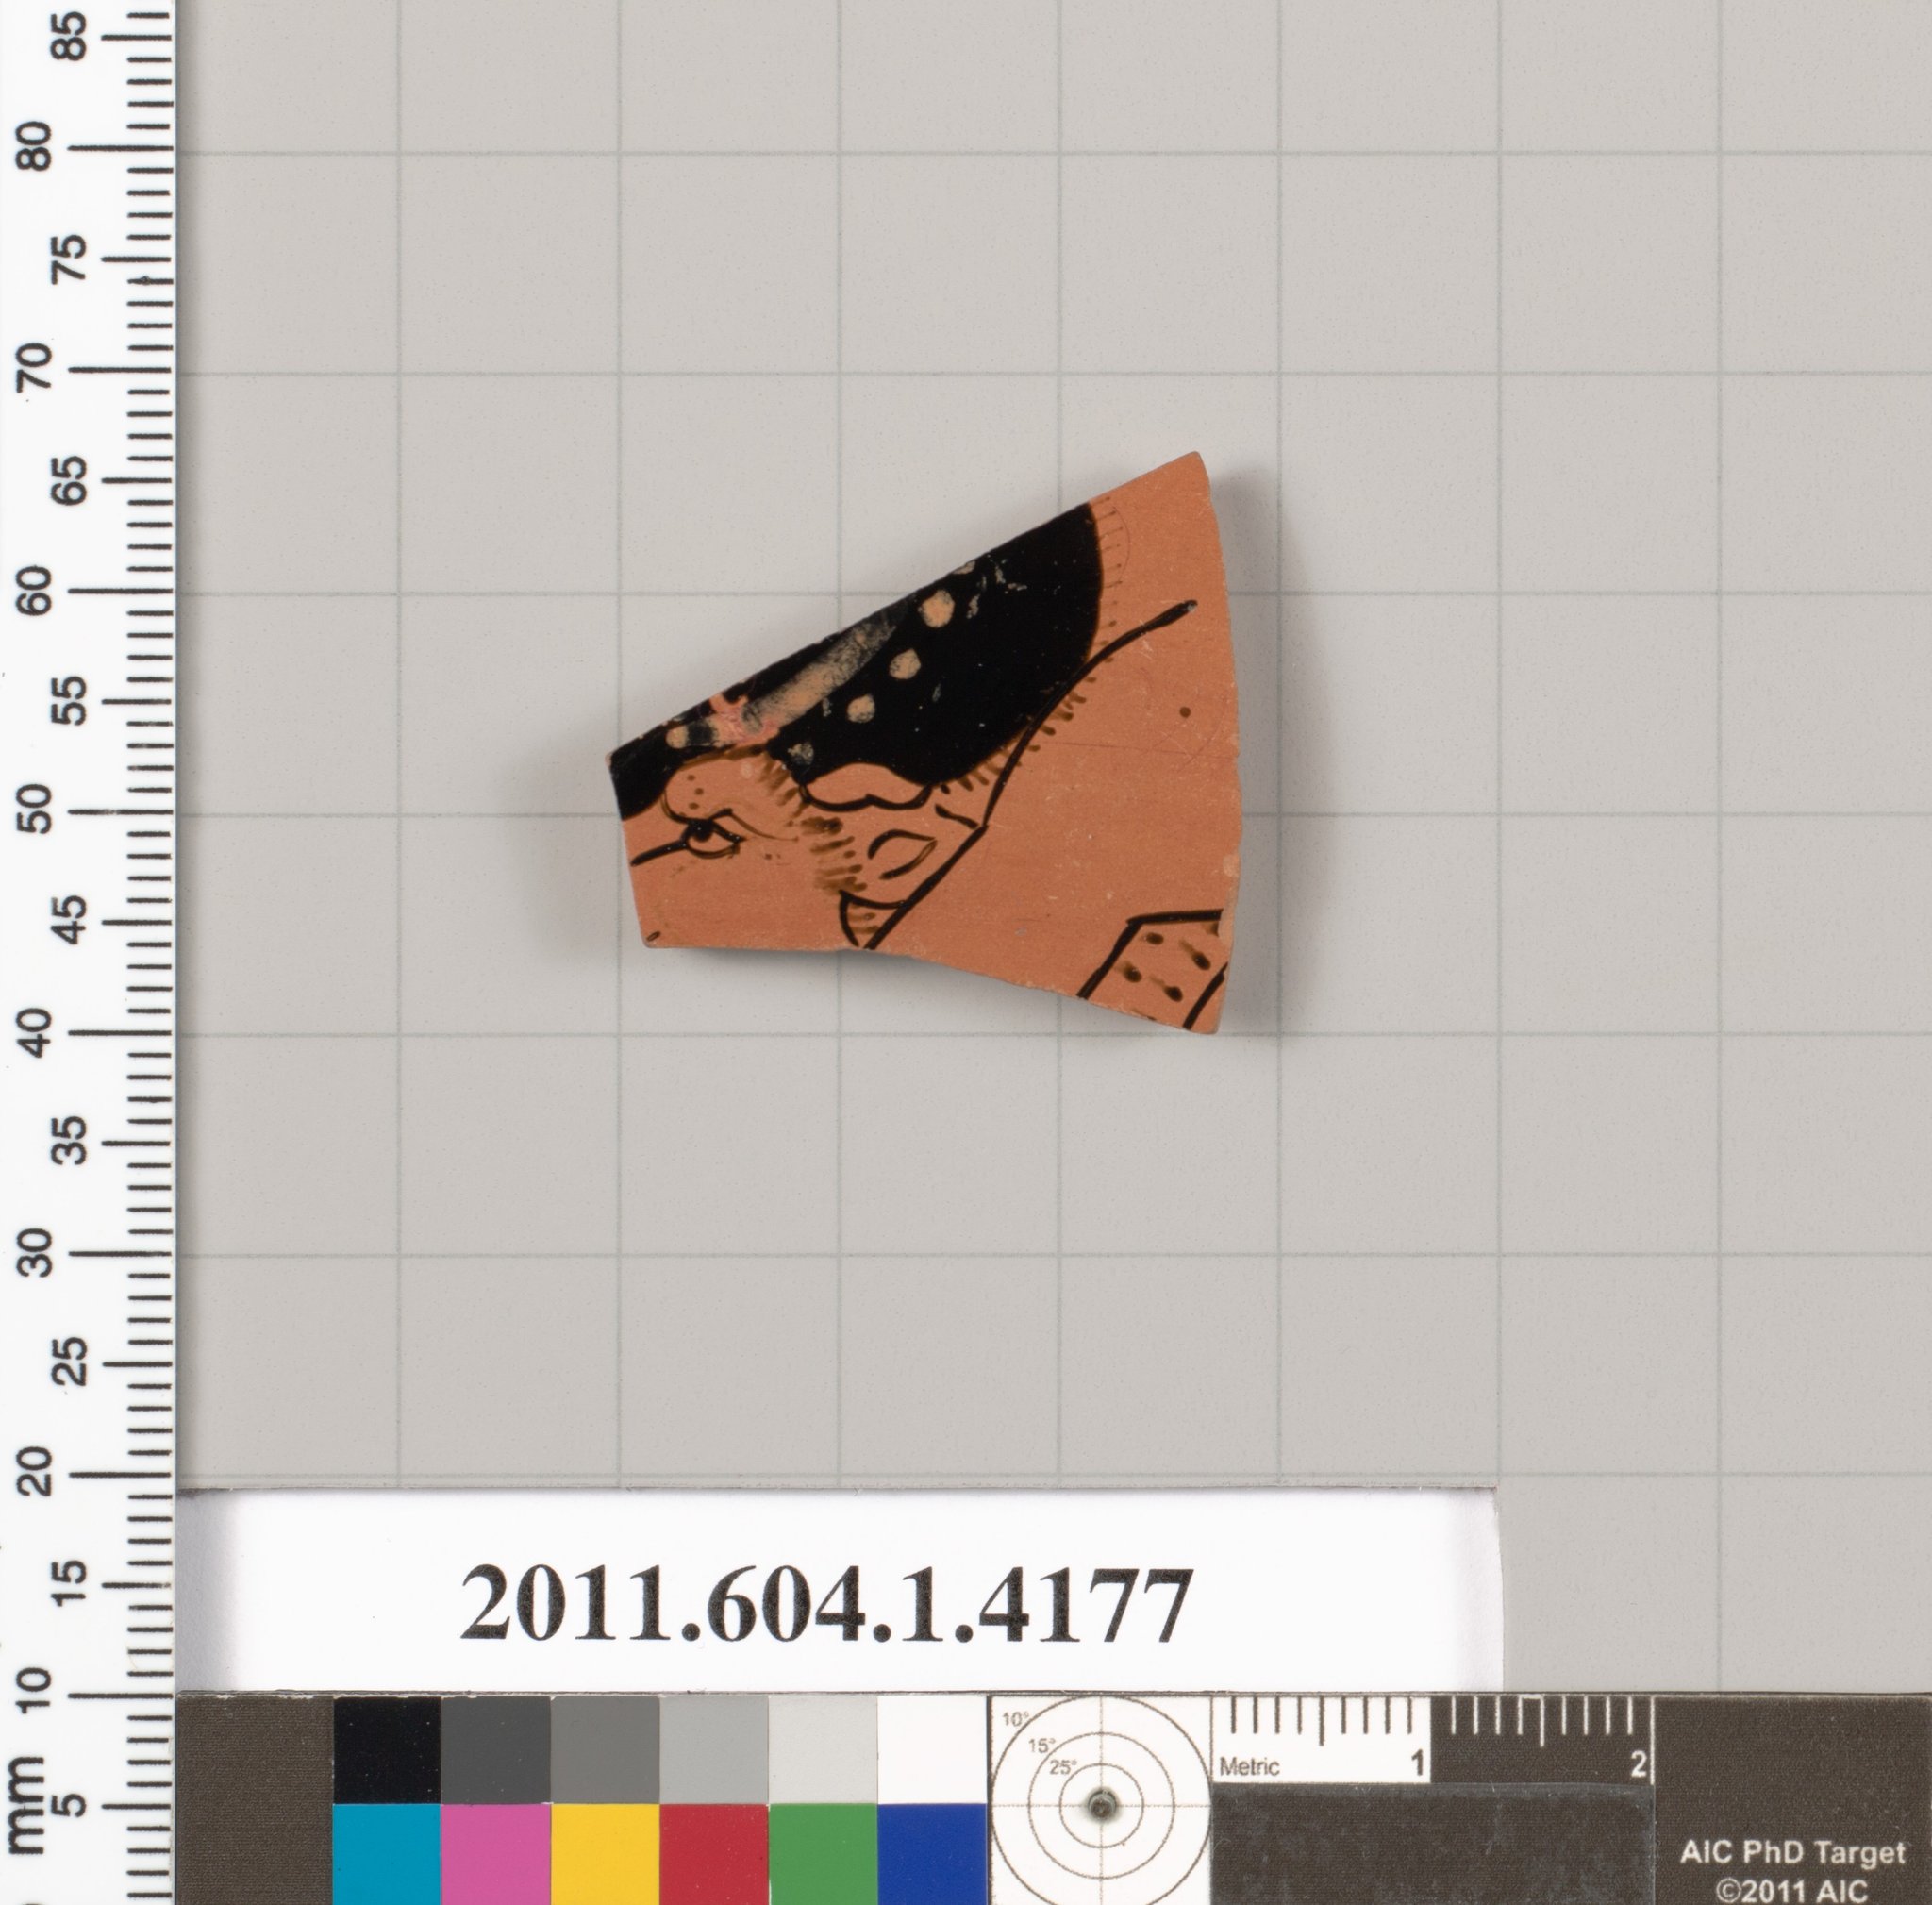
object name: kylix fragment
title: Terracotta fragment of a kylix (drinking cup)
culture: greek, attic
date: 500-480 BCE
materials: terracotta